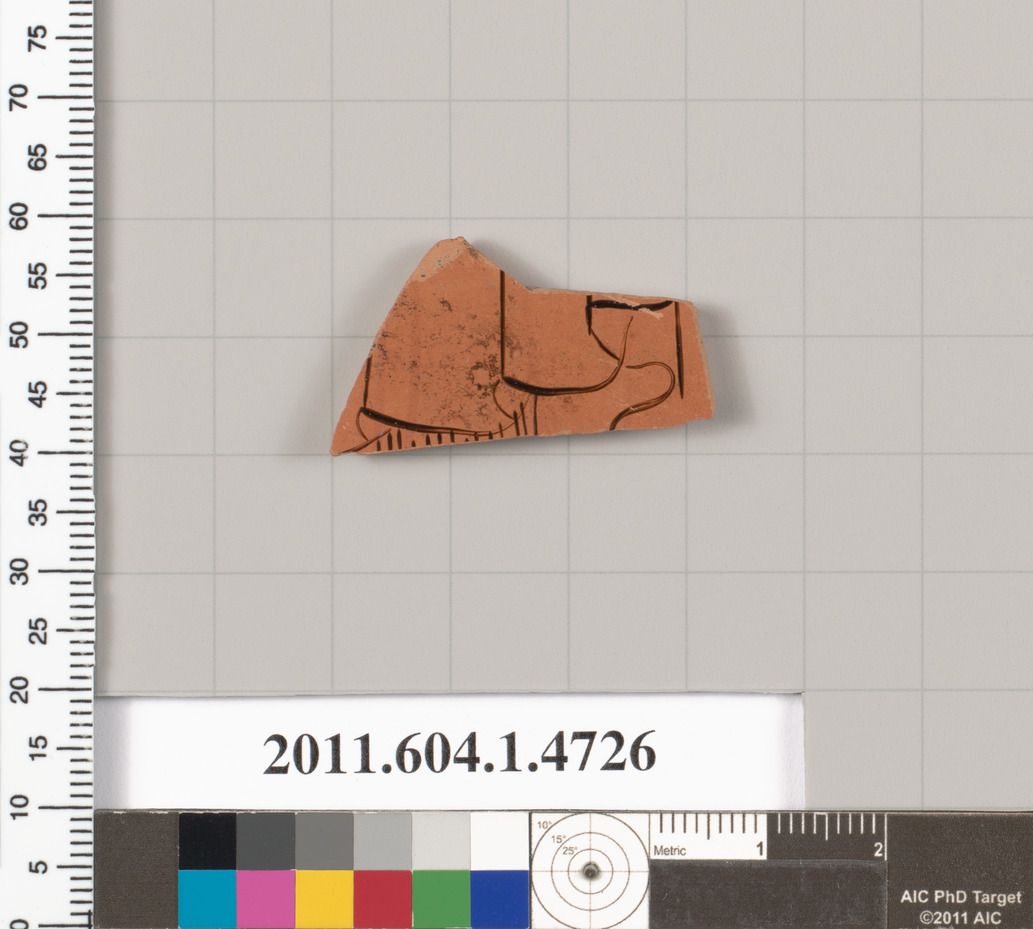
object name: kylix fragment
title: Terracotta fragment of a kylix (drinking cup)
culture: greek, attic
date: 490-480 BCE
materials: terracotta